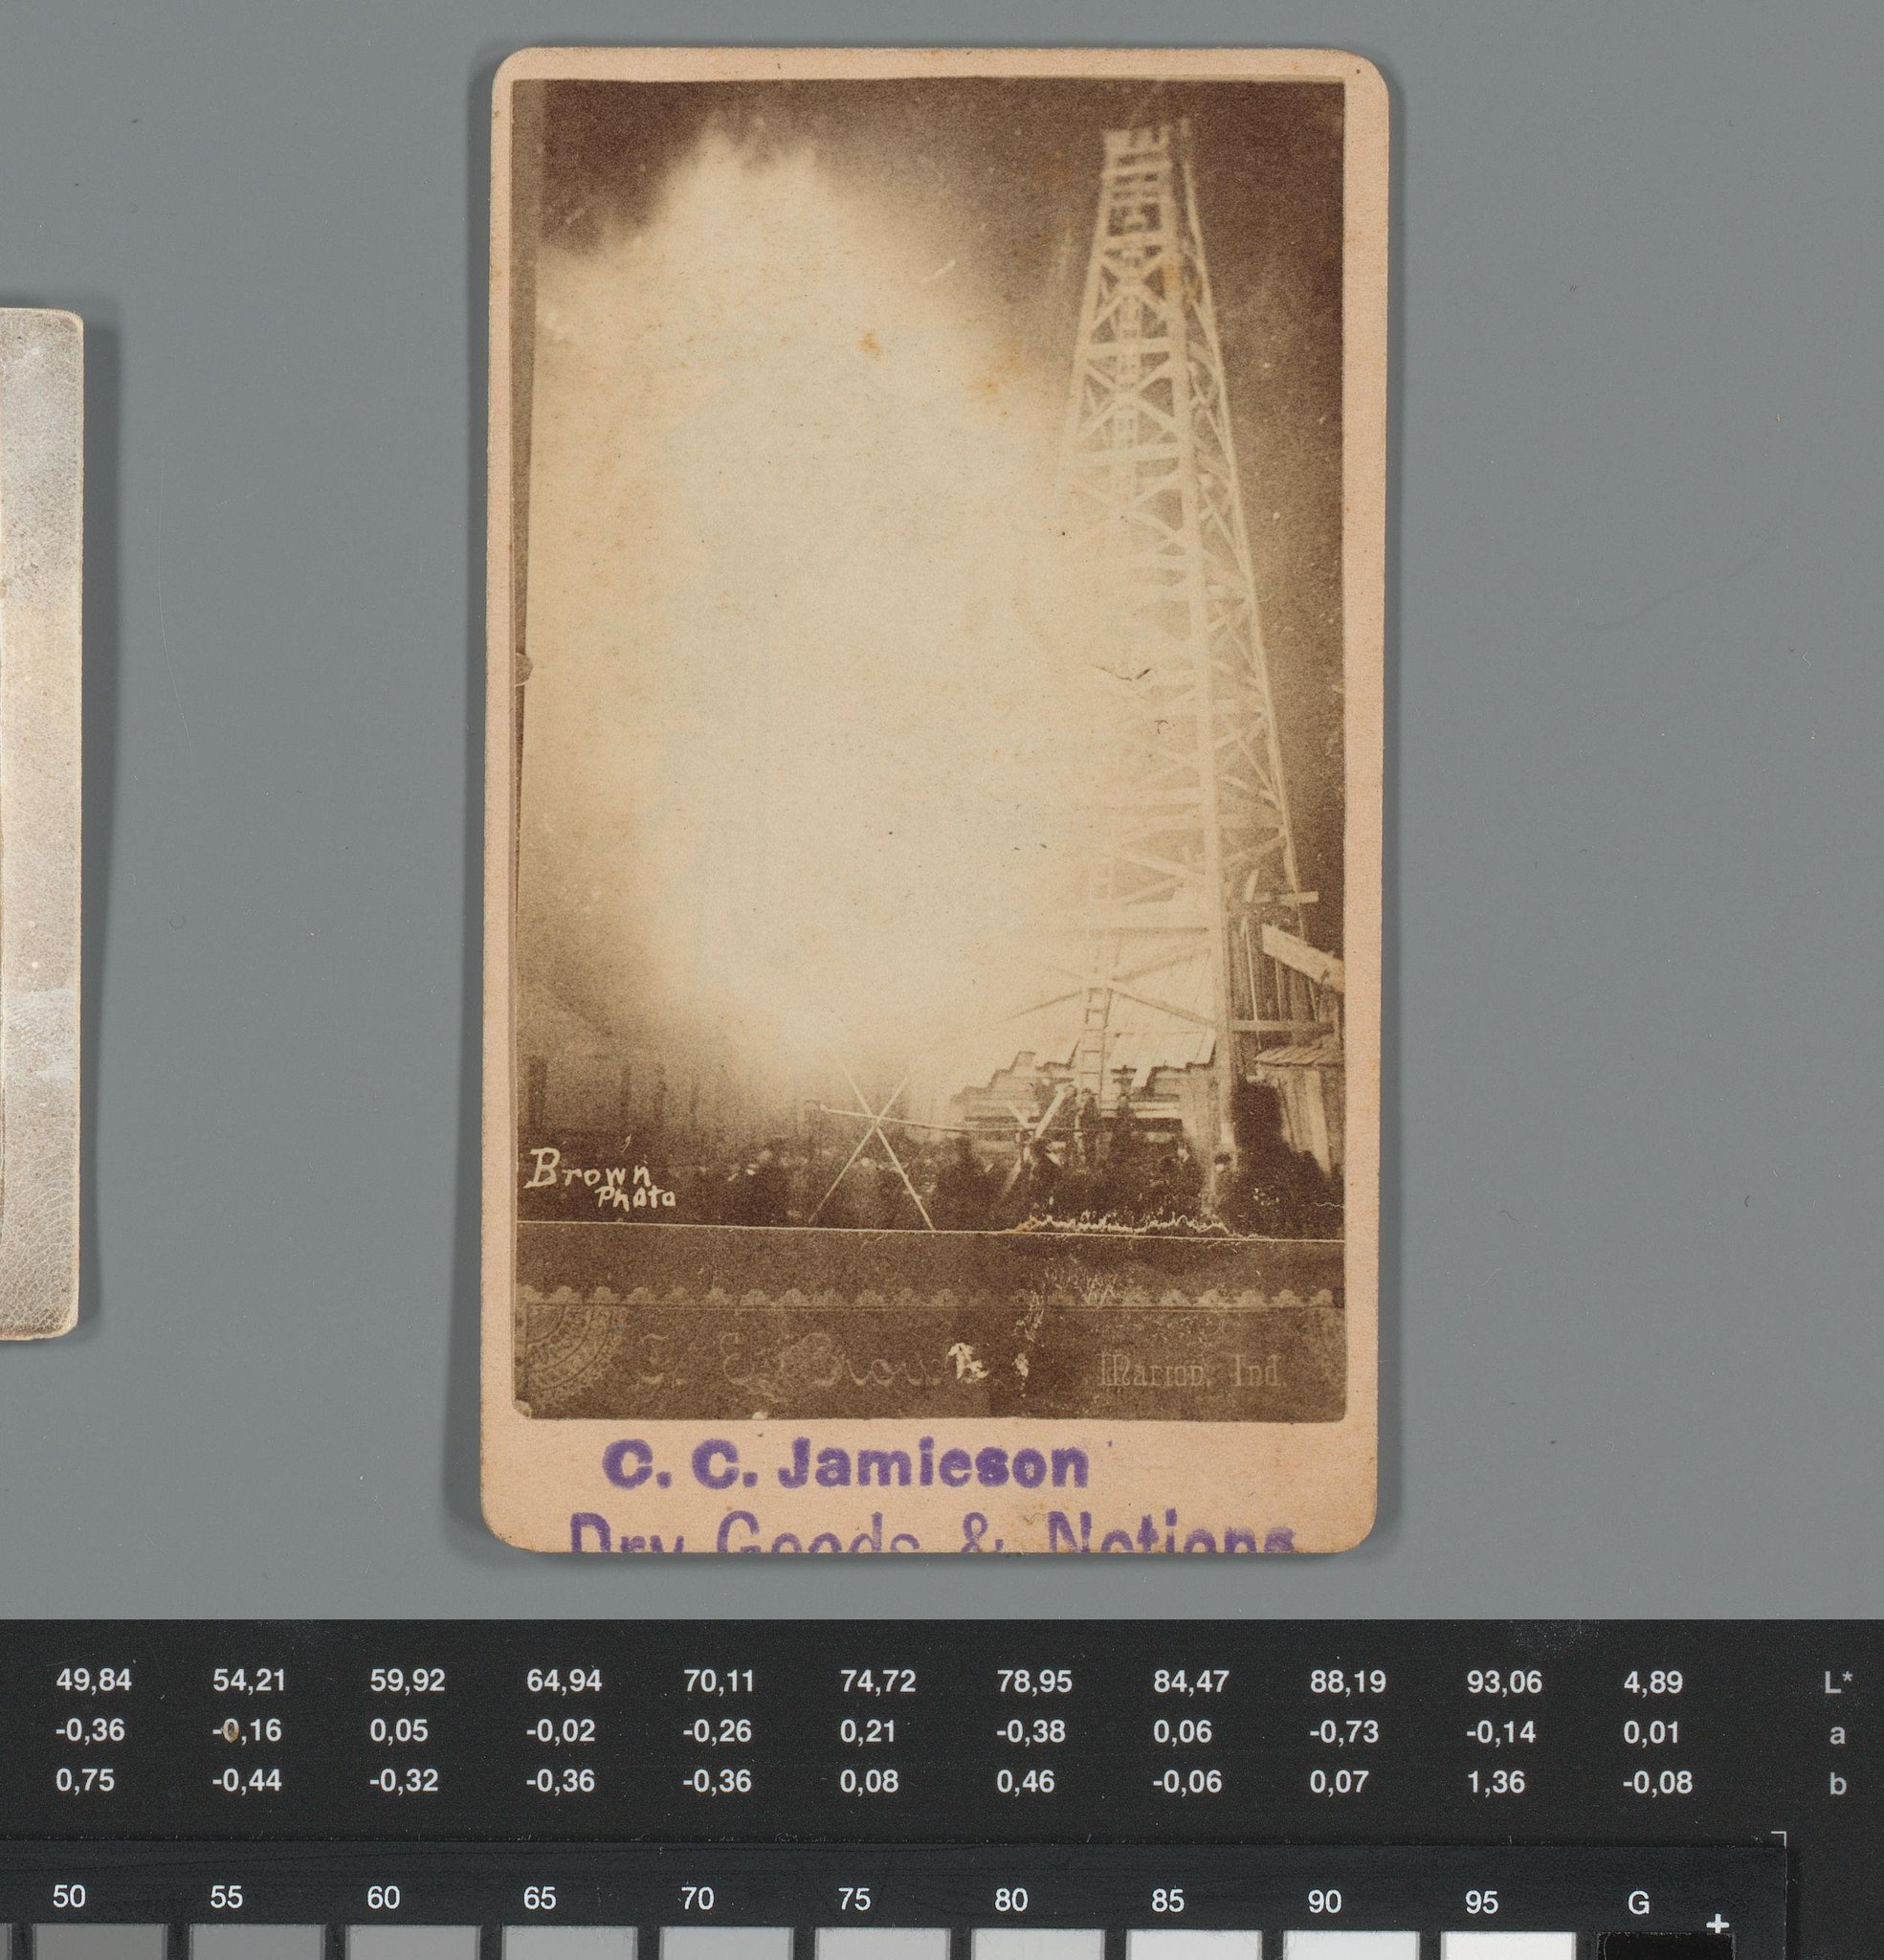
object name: photograph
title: Gezicht op gaswinning in Marion, Indiana, met reclame voor de opening van de winkel van C.C. Jamieson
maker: brown (fotograaf)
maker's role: fotograaf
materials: cardboard, photographic support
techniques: albumen print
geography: marion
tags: advertising, gasworks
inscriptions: name: ‘Brown/ Photo/ [...]. E. Brown Marion, Ind.’